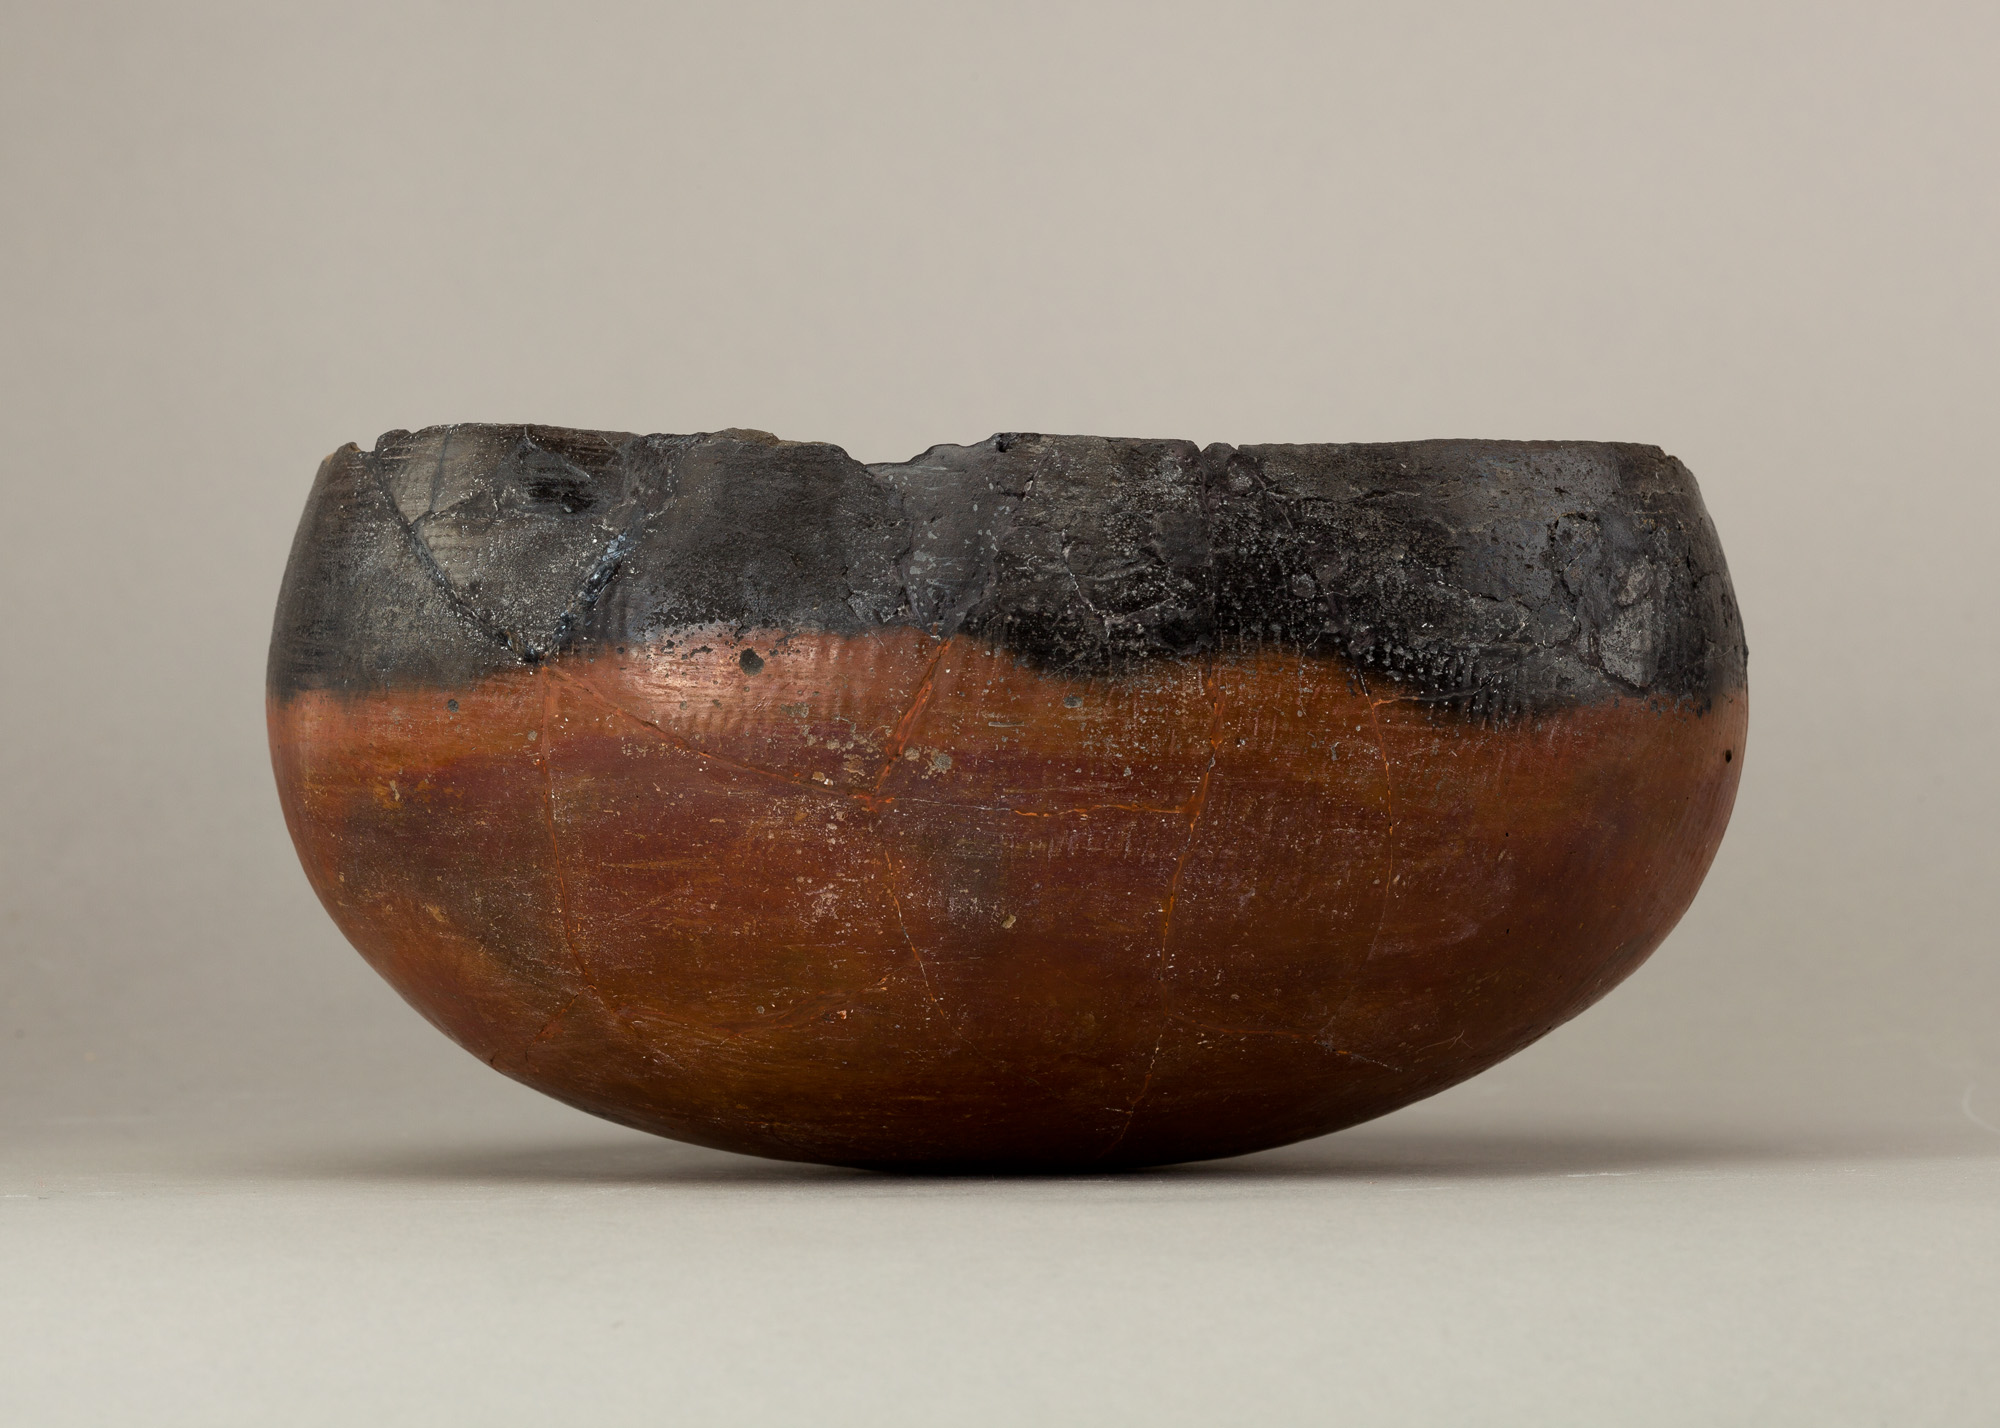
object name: bowl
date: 4400-3800 BCE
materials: pottery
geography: egypt